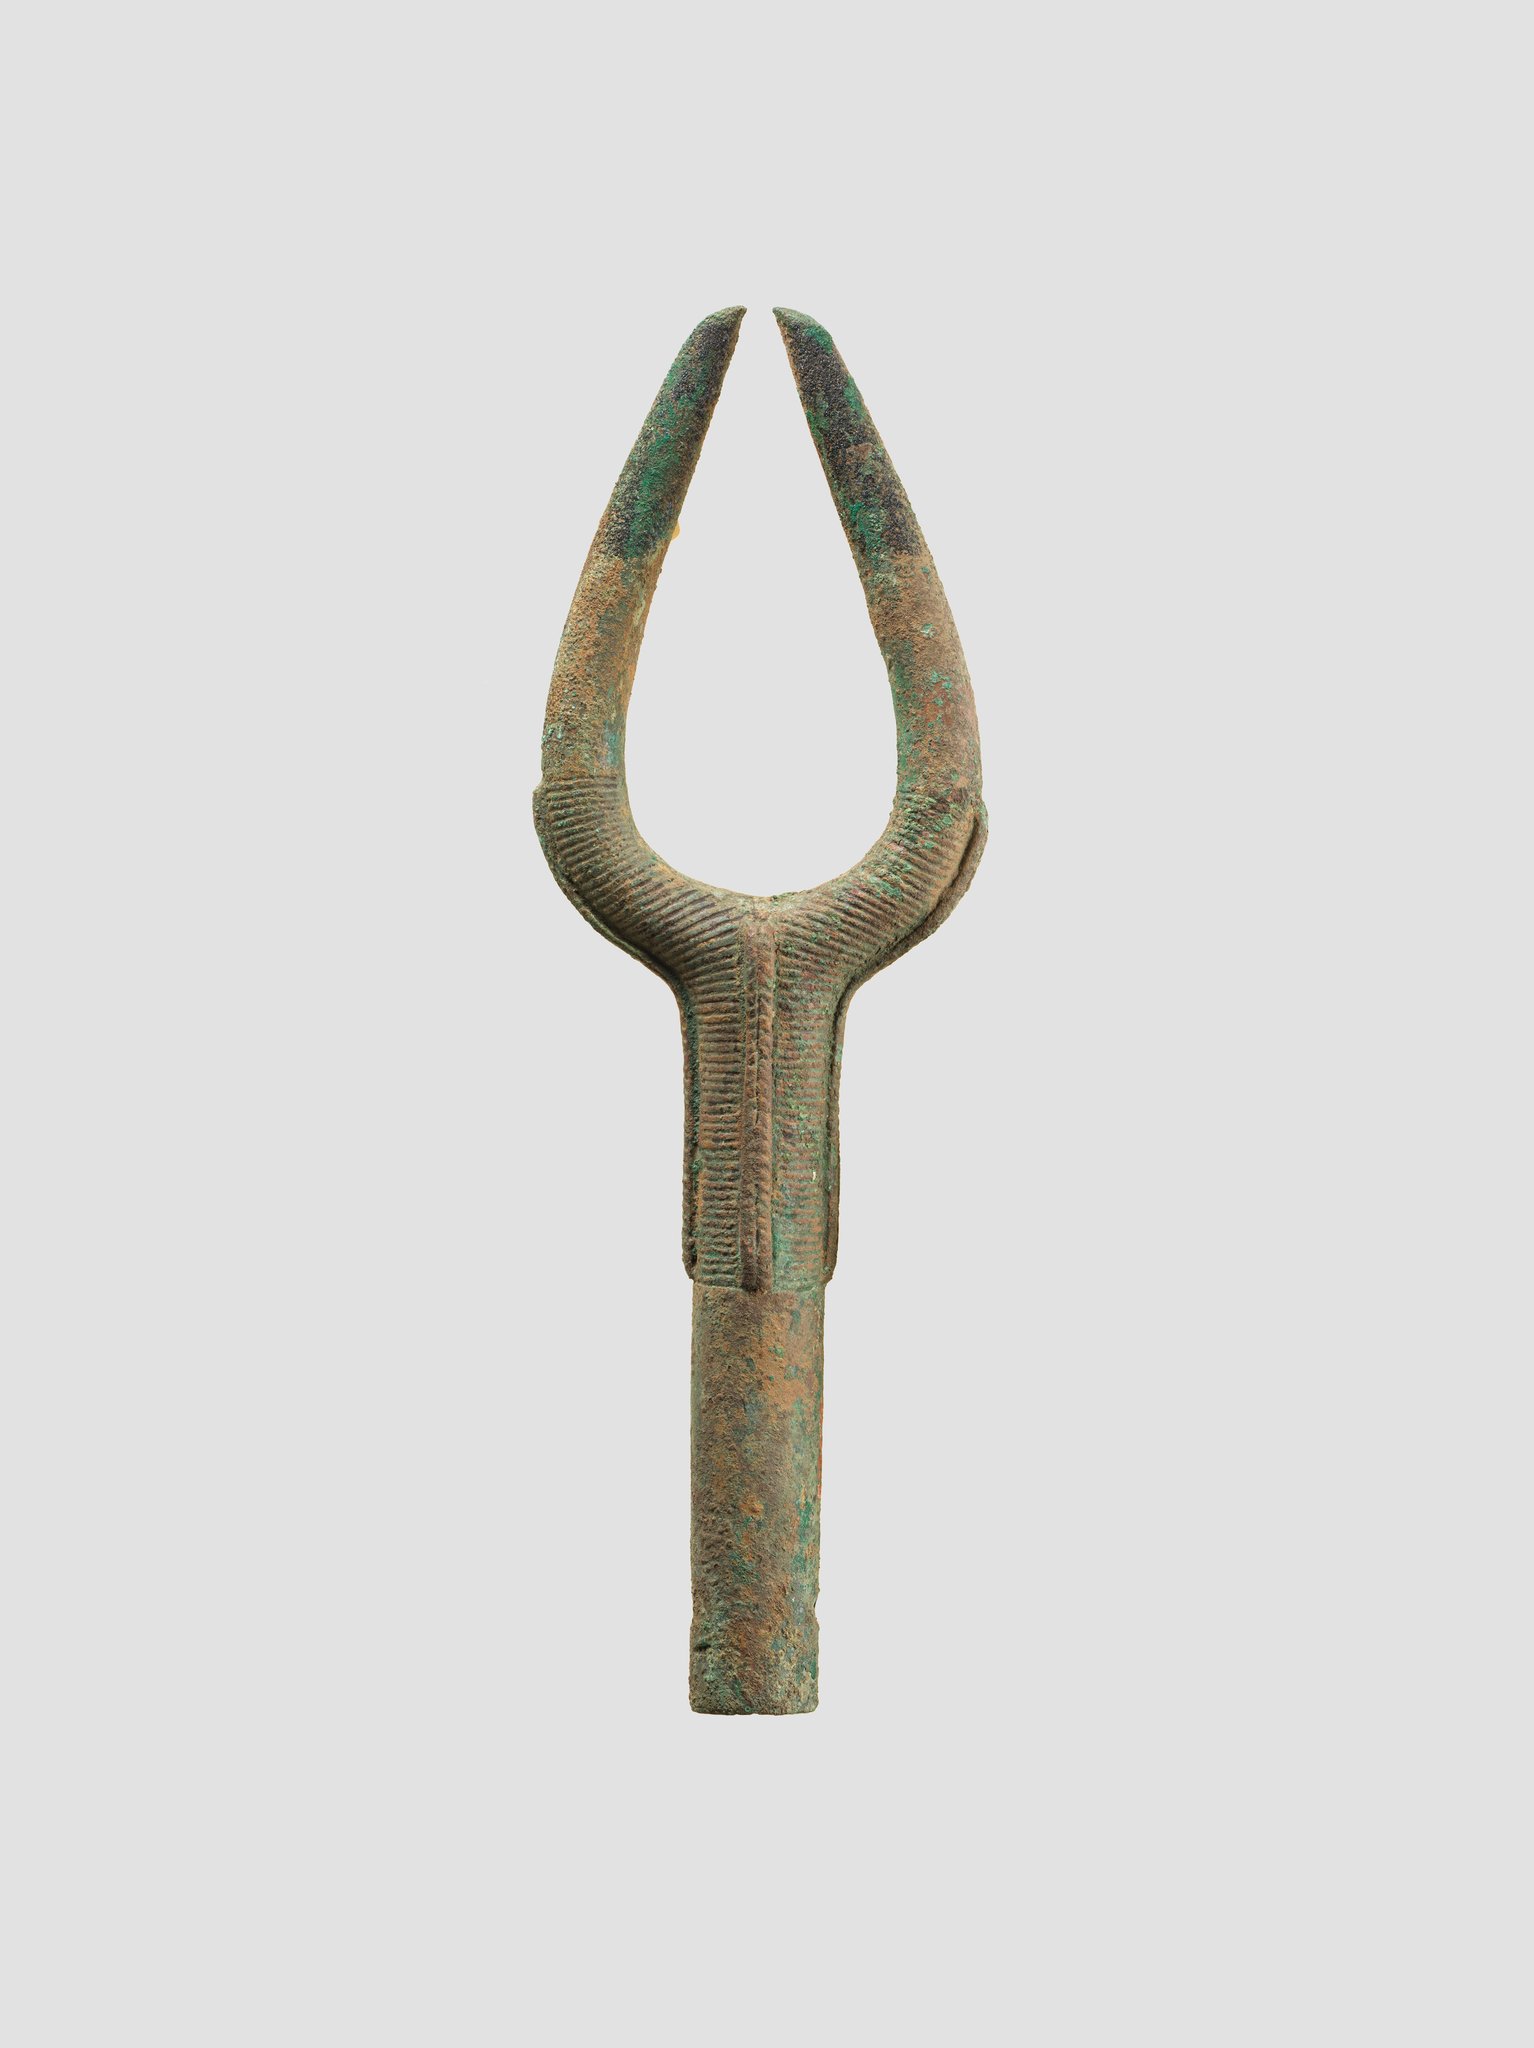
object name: staff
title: Staff (?)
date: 2000-1001 BCE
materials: bronze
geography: levant